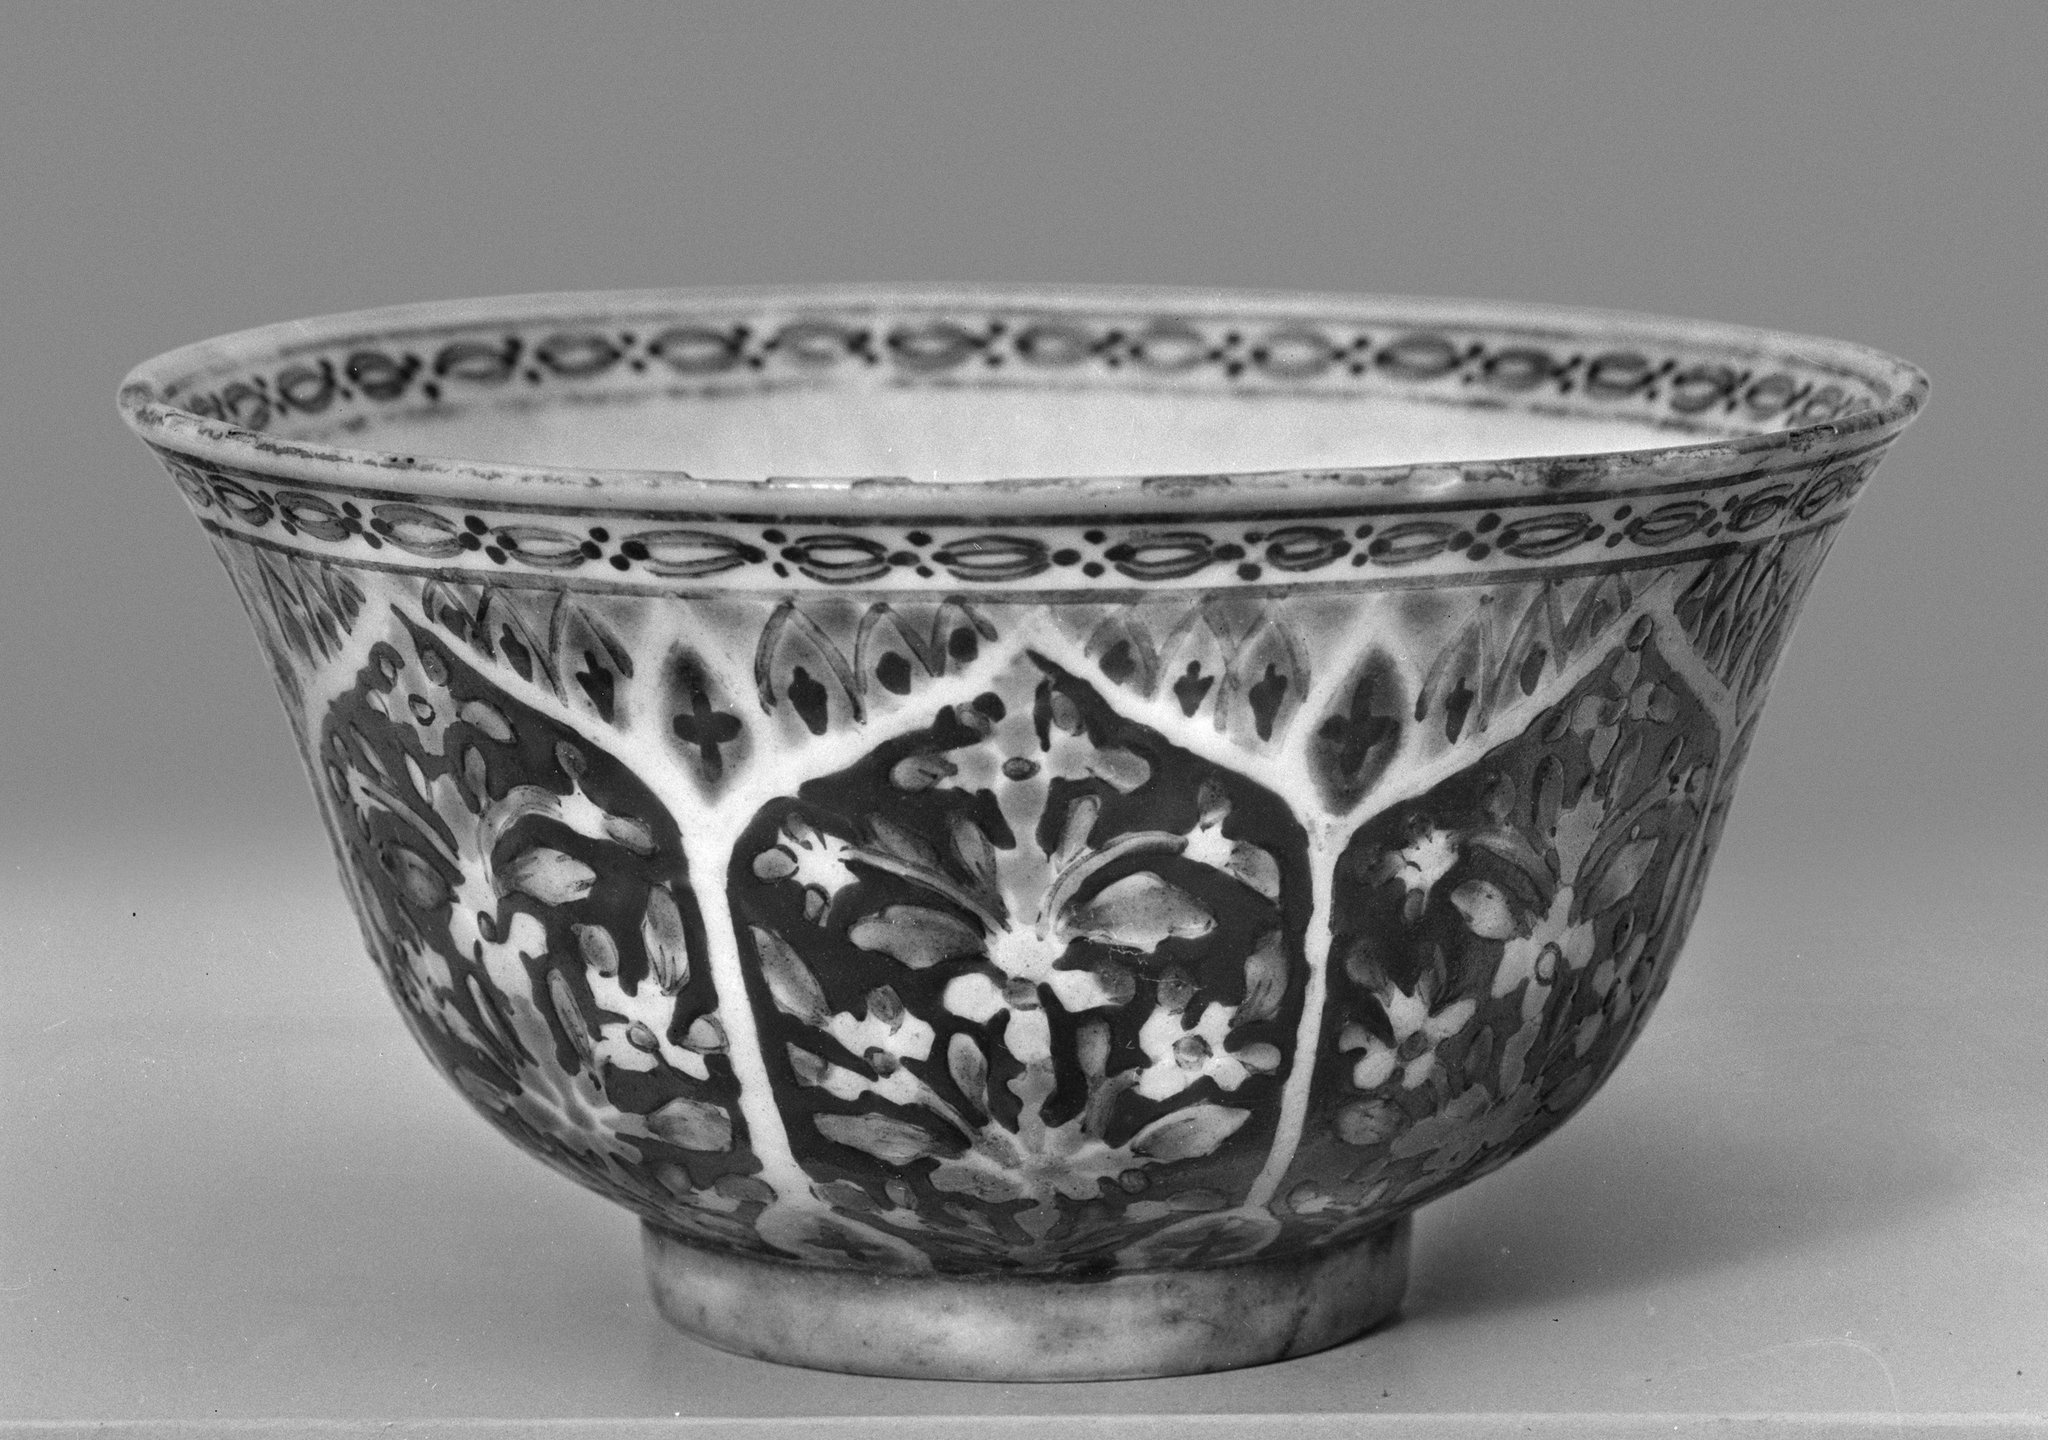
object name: bowl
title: Bowl with floral pattern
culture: chinese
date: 1801-1900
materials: enamel, porcelain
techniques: overglaze, painting, polychrome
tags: flowers